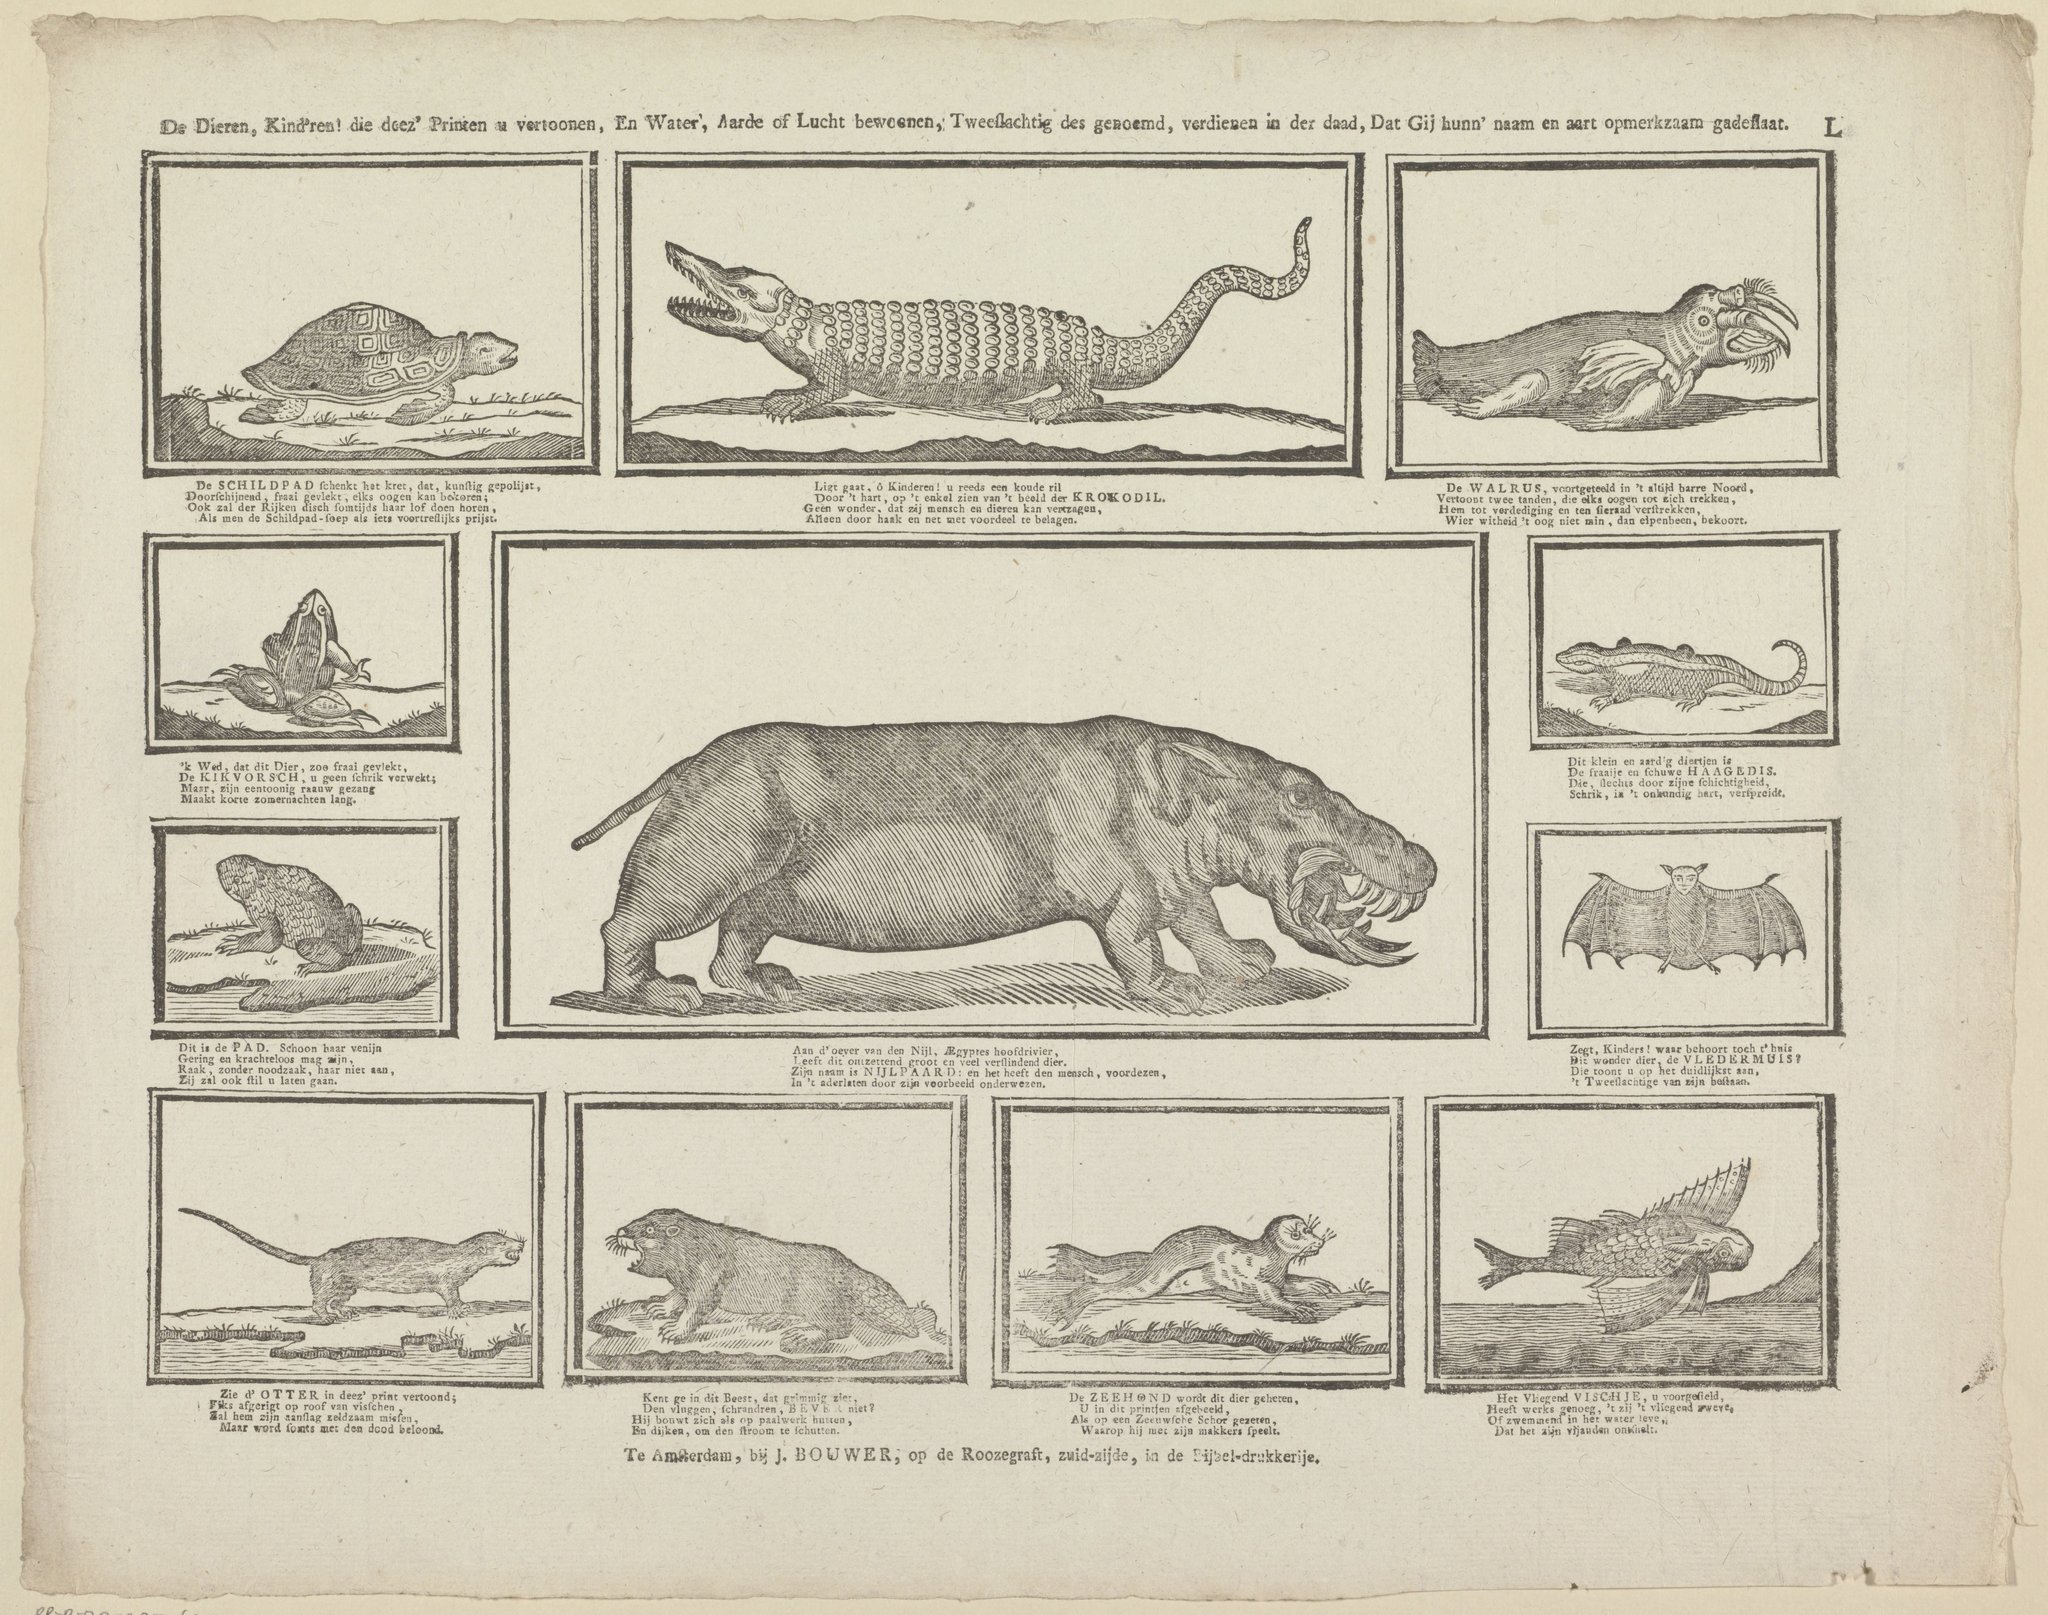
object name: popular print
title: De dieren, kind'ren! die deez' print u vertoonen, En water, aarde of lucht bewoonen, Tweeslachtig des genoemd, verdienen in der daad, Dat gij hunn' naam en aart opmerkzaam gadeslaat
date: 1805-1808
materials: paper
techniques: letterpress printing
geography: amsterdam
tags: mammals, amphibians, reptiles, fishes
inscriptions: collector's mark: Lugt 2760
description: Blad met 12 voorstellingen van amfibieën, reptielen, zoogdieren en een vis. Onder elke afbeelding een vierregelig vers met de naam van het dier. Genummerd rechtsboven: L.